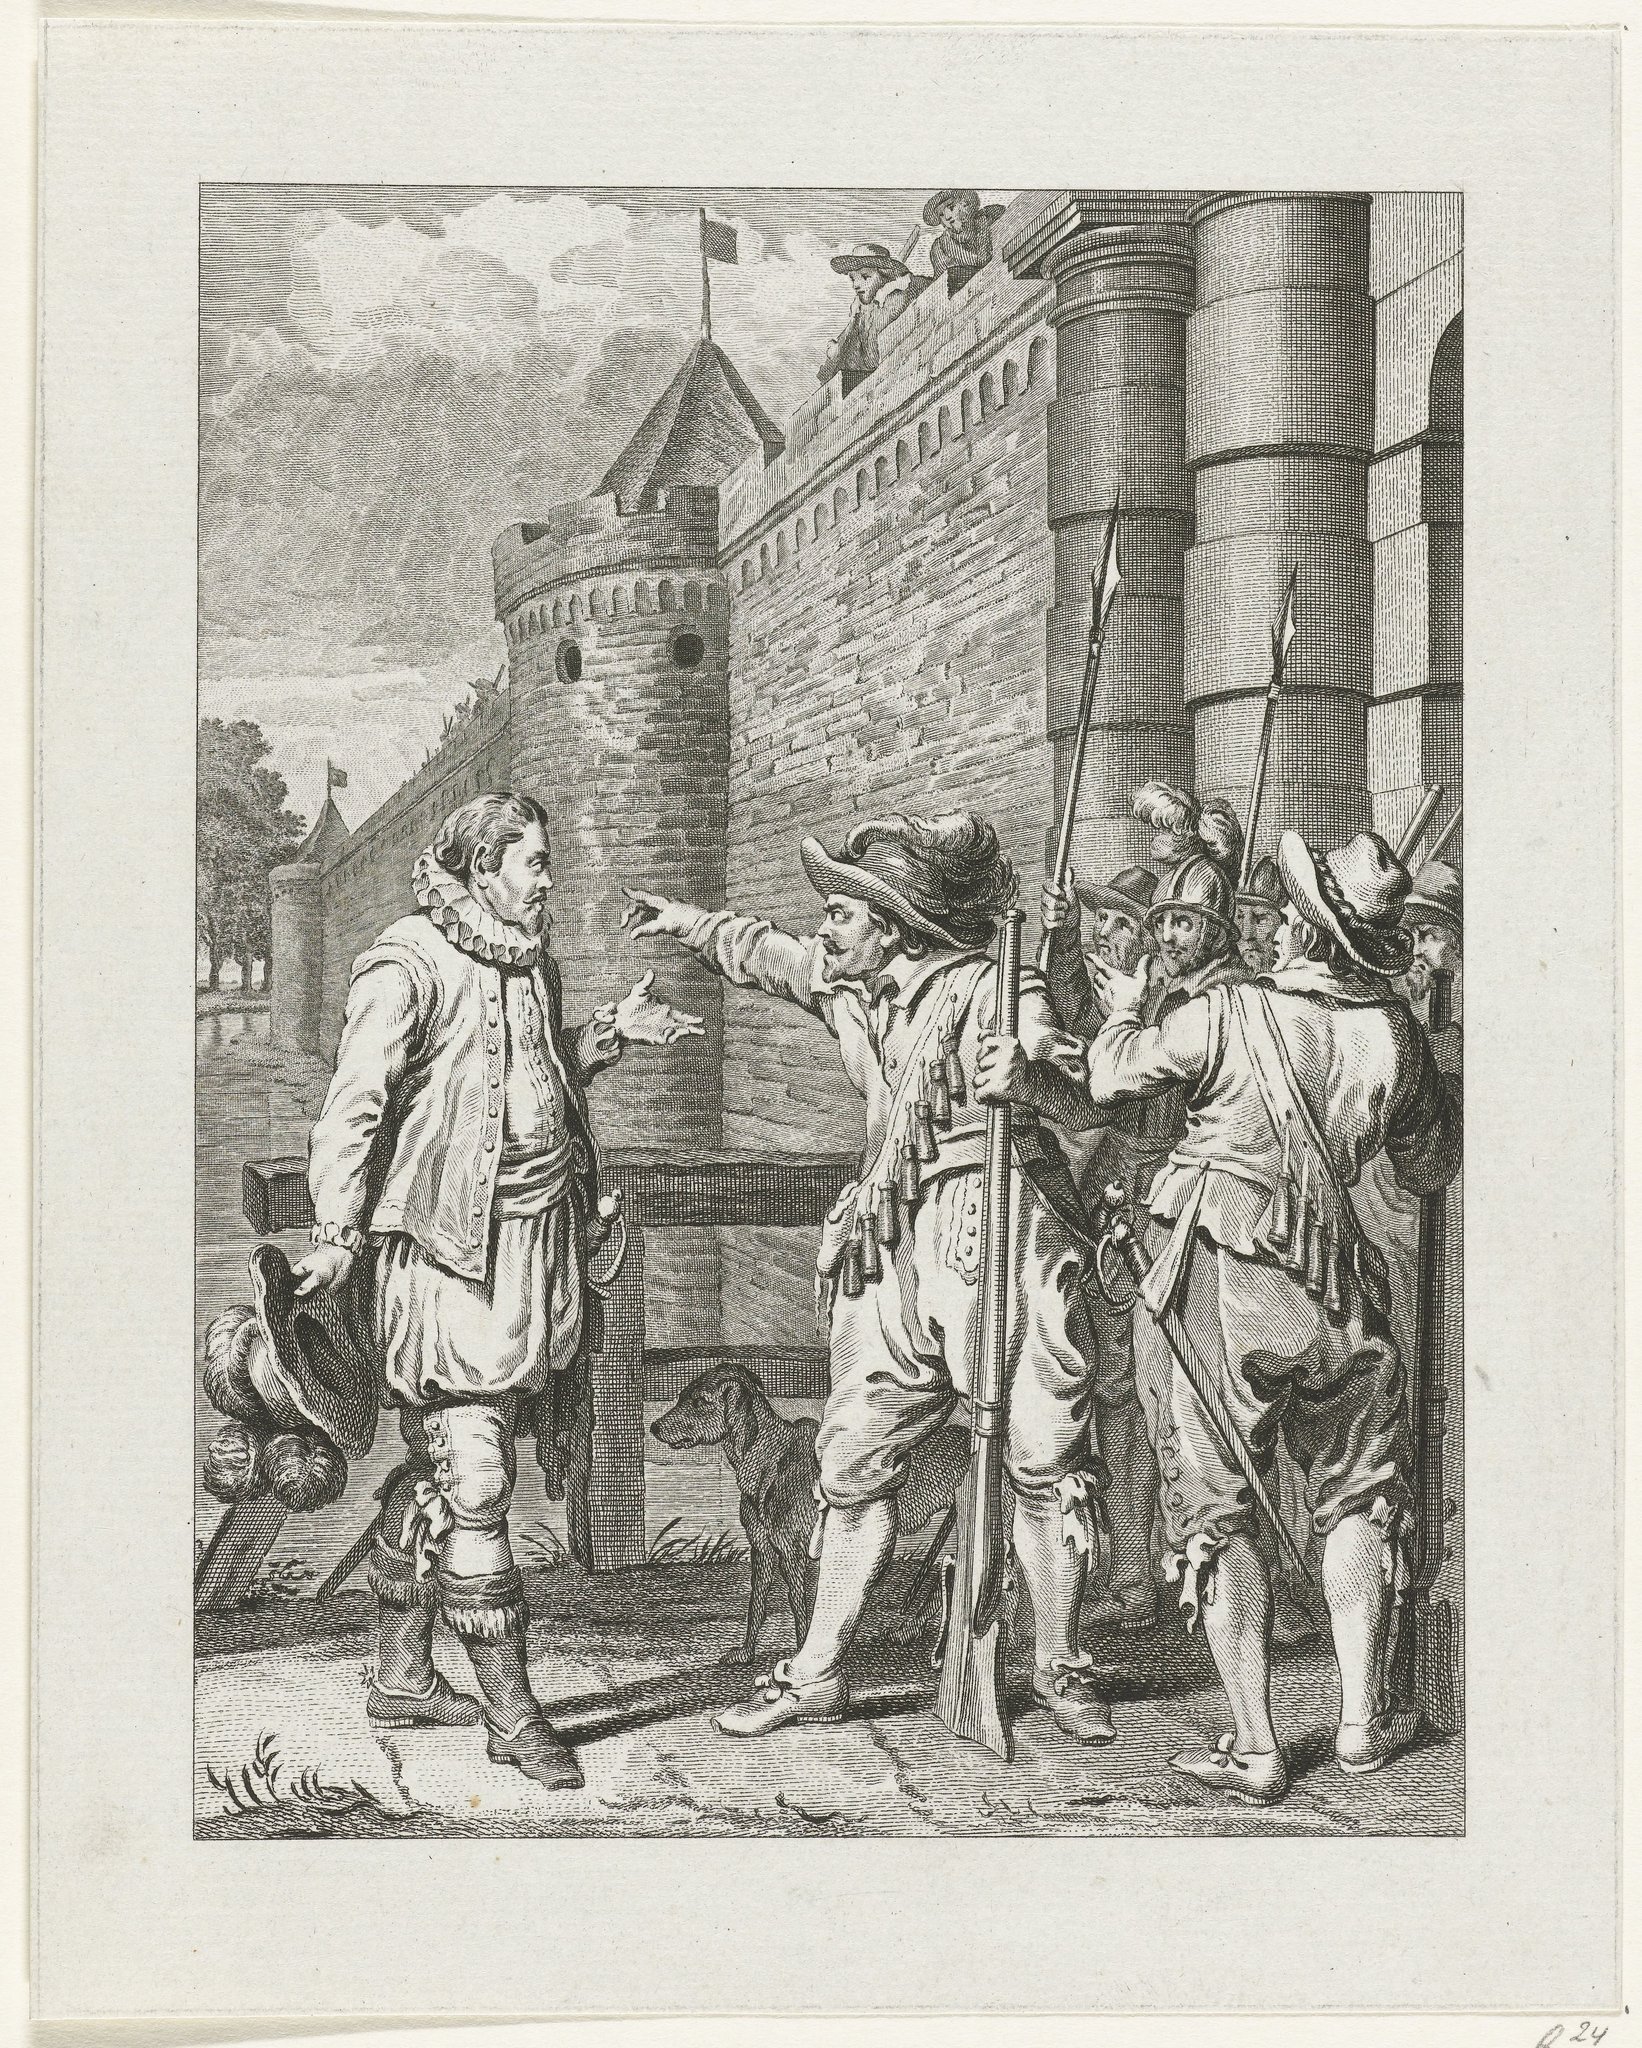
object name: history print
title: Oranje bezoekt alleen het opstandige Gent, ca. 1579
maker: cornelis brouwer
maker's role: print maker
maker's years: 1731-1803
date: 1788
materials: paper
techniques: etching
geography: northern netherlands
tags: delft, william i (prince of orange), ghent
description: Illustratie voor: J. Nomsz, Willem de eerste, of de grondlegging der Nederlandsche vryheid. : In vier en twintig zangen, Erven van David Klippink, Amsterdam 1779. Staat vóór de letter.